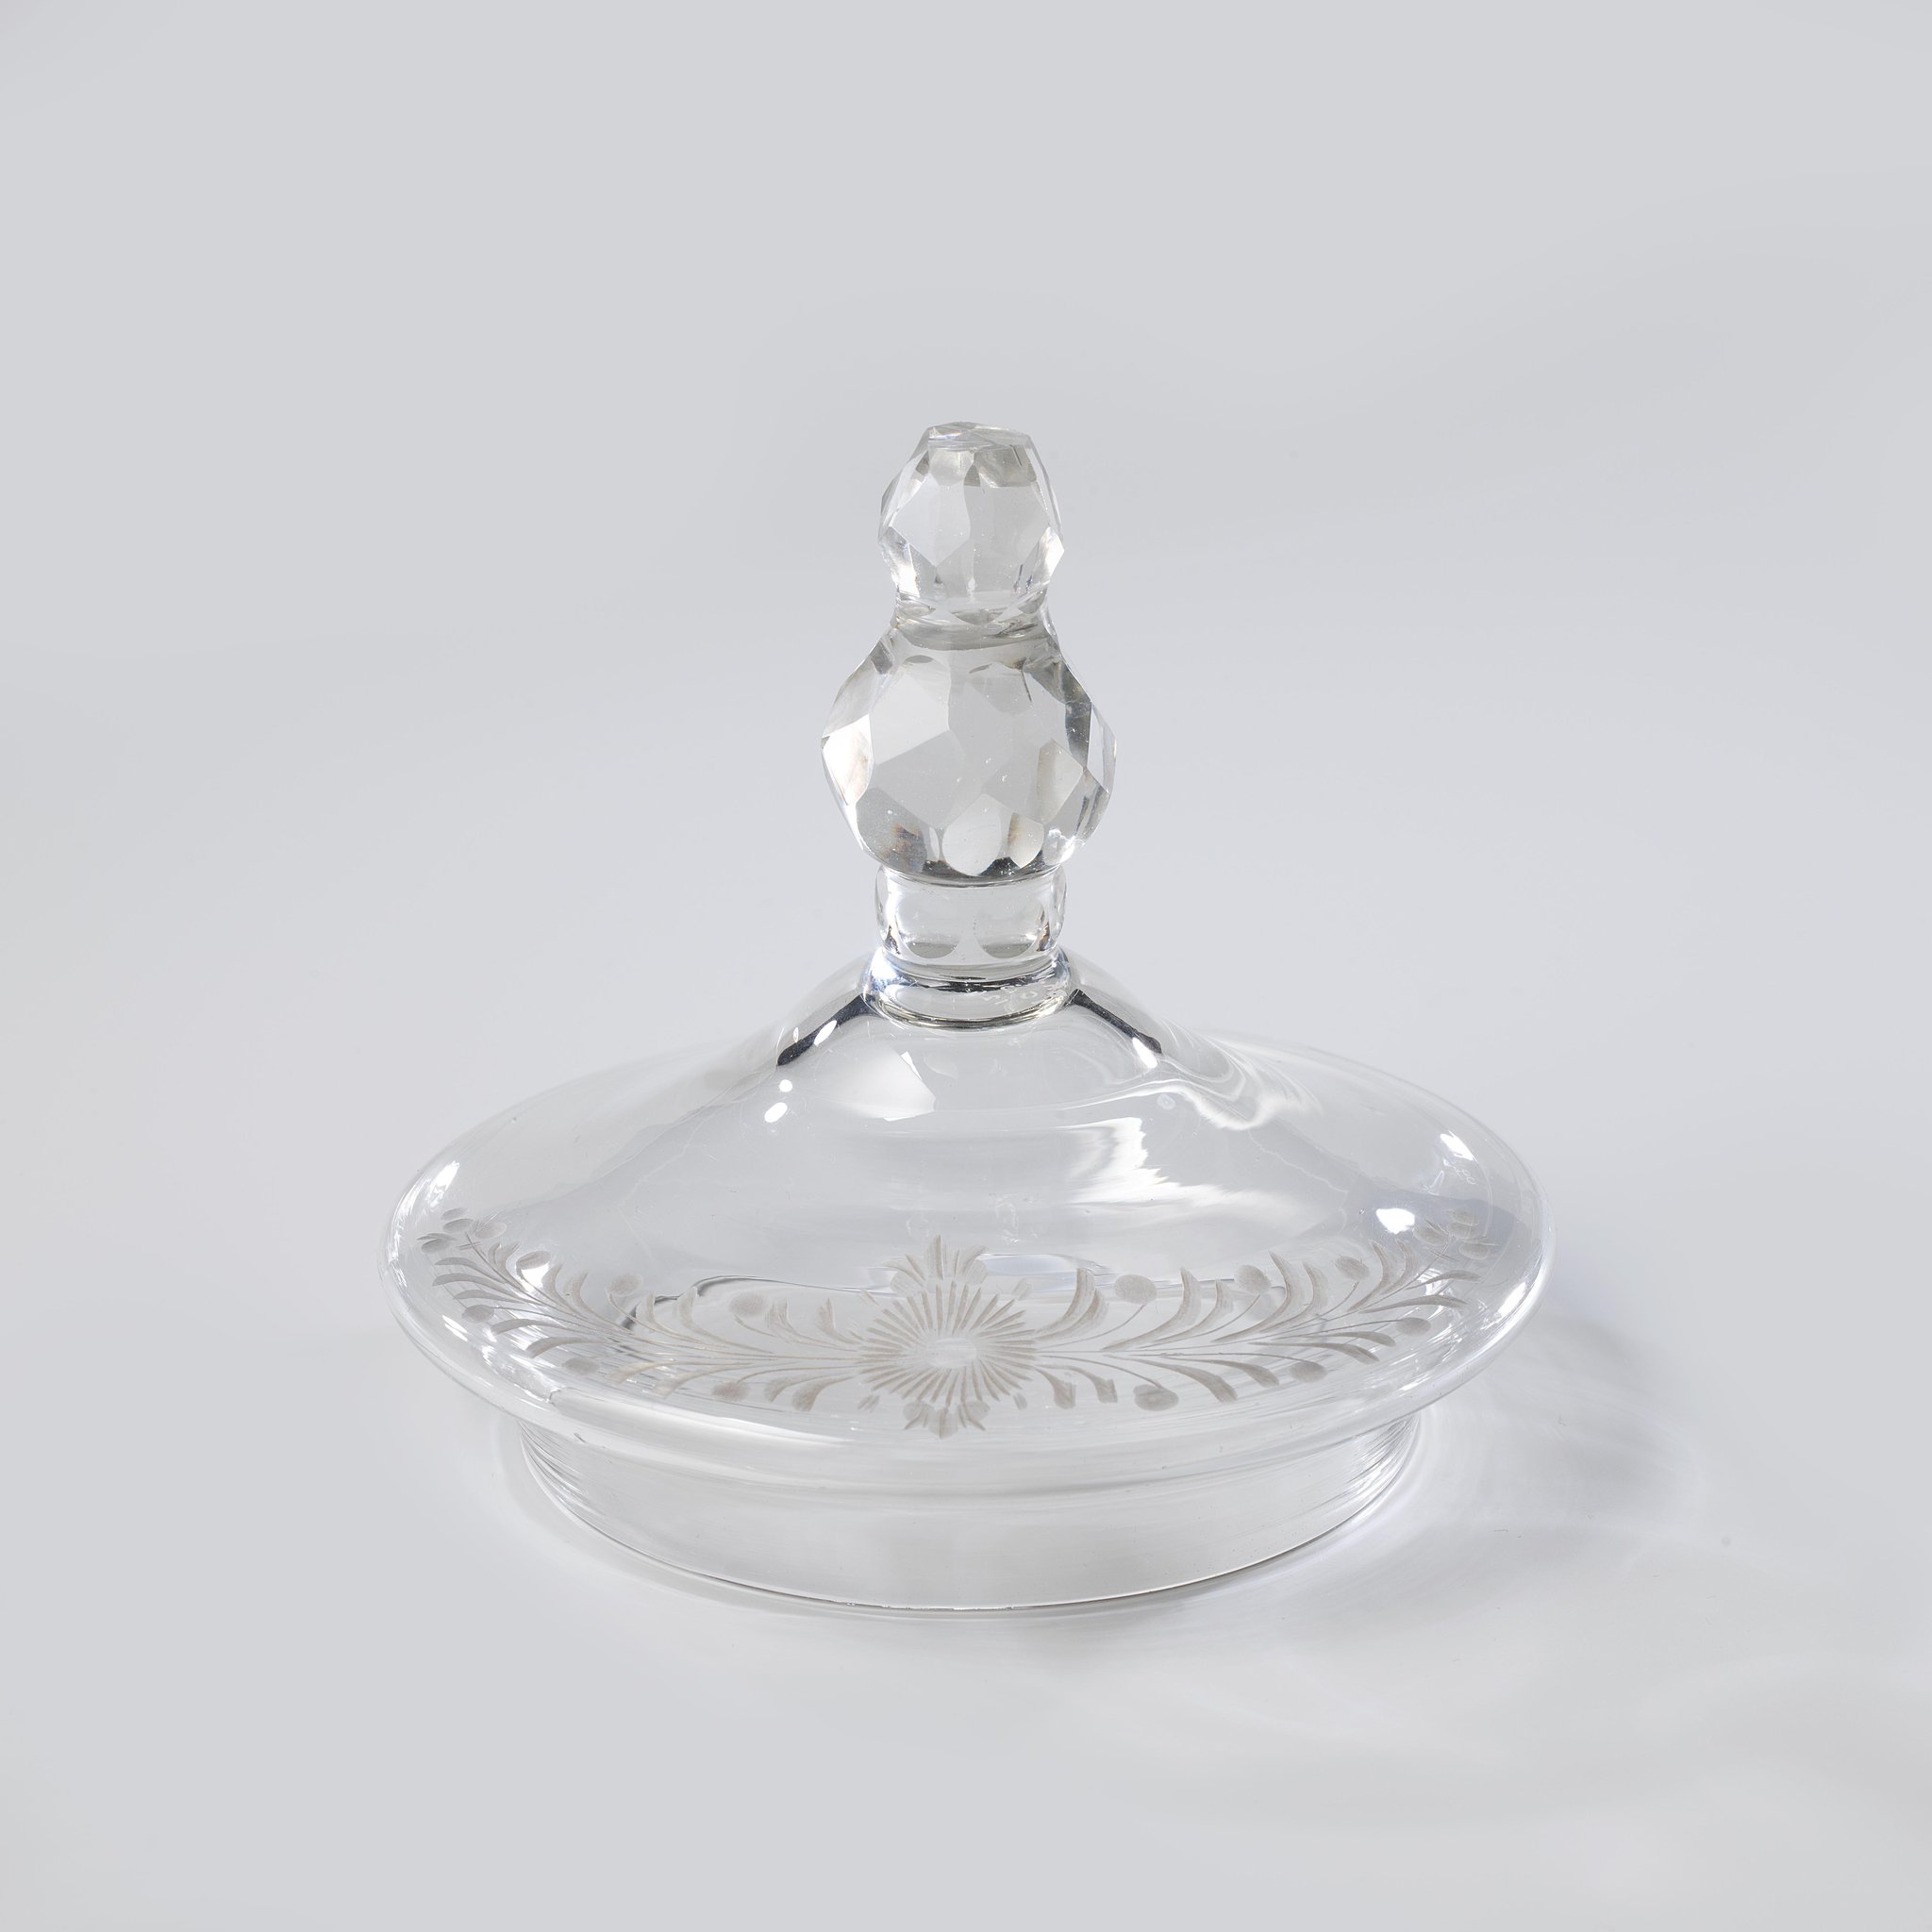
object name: lid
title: Deksel van een grote bokaal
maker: Anonymous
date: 1750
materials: glass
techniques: glassblowing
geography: germany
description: Gewelfde deksel, bekroond met gelede dekselknop, bestaande uit twee gefacetteerde knopen en een gefacetteerde peervormige uiteinde. Op de deksel een gegraveerd bloem- en bladornament.